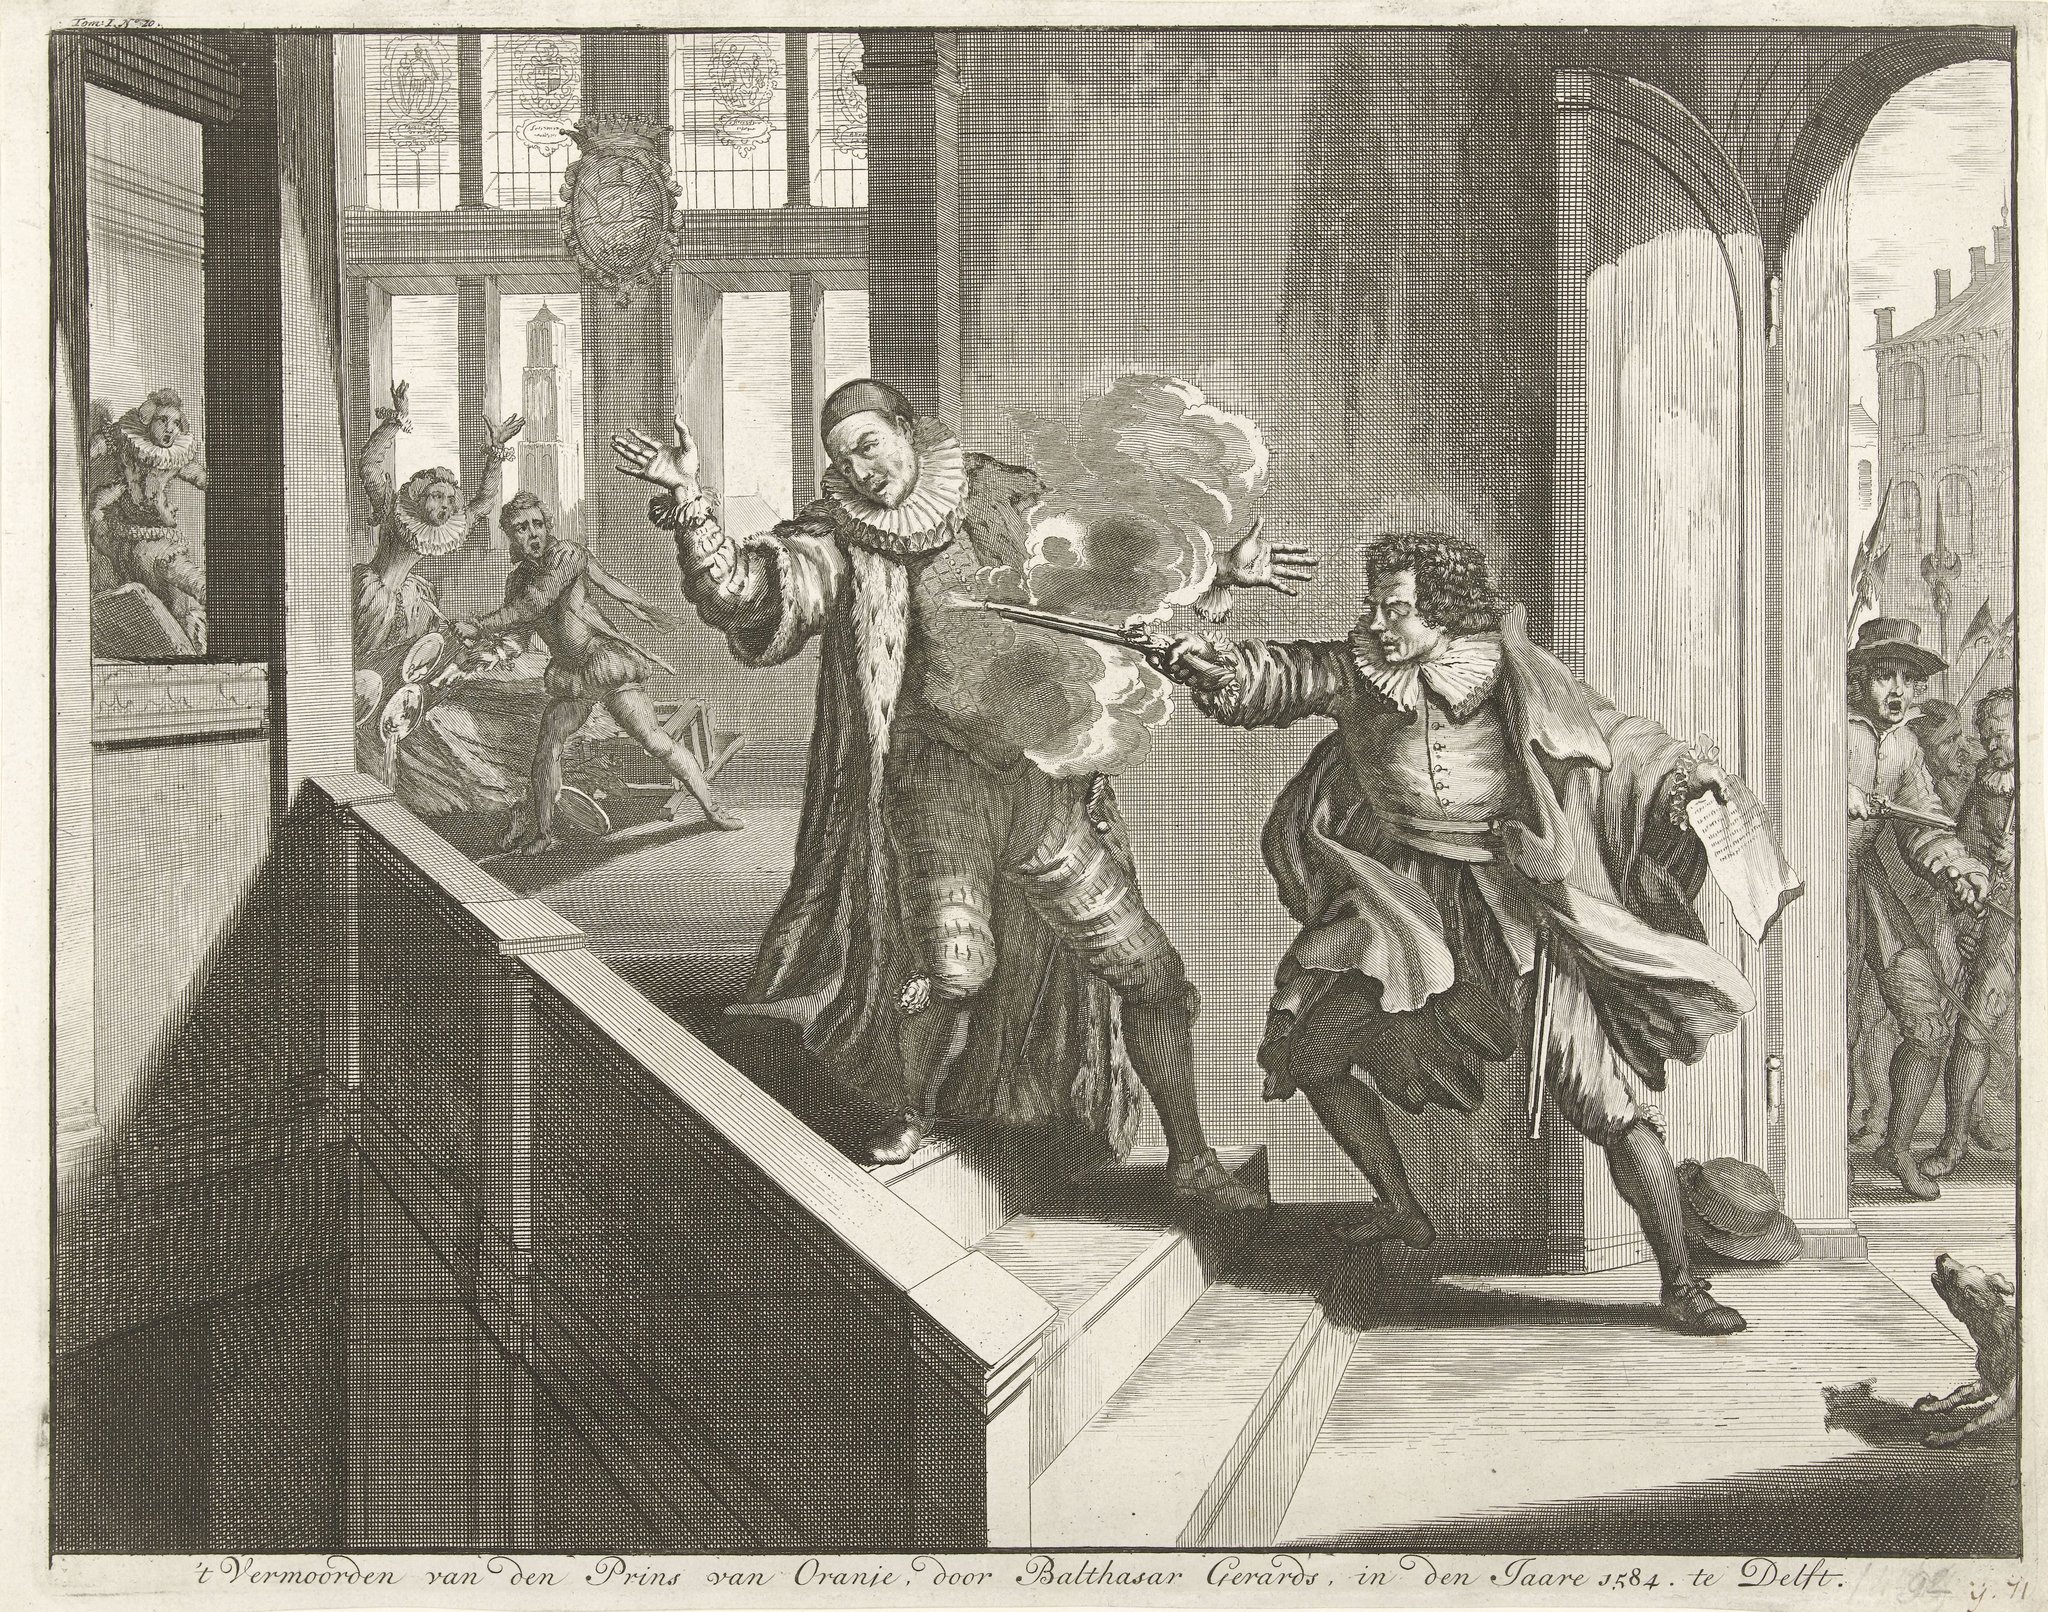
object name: print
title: Moord op de prins van Oranje, 1584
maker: jan luyken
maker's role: draughtsman, print maker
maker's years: 1649-1712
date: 1678-1680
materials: paper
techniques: engraving, etching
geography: northern netherlands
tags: delft, william i (prince of orange), attempt, political murder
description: J. le Clerc, Geschiedenissen der Vereenigde Nederlanden, sedert den aanvang van die Republyk tot op den Vrede van Utrecht in 't jaar 1713 en het Tractaat van Barriere in 't jaar 1715 gesloten, Z. Chatelain, Amsterdam 1730, 3 delen, Tom. I. No. 20.